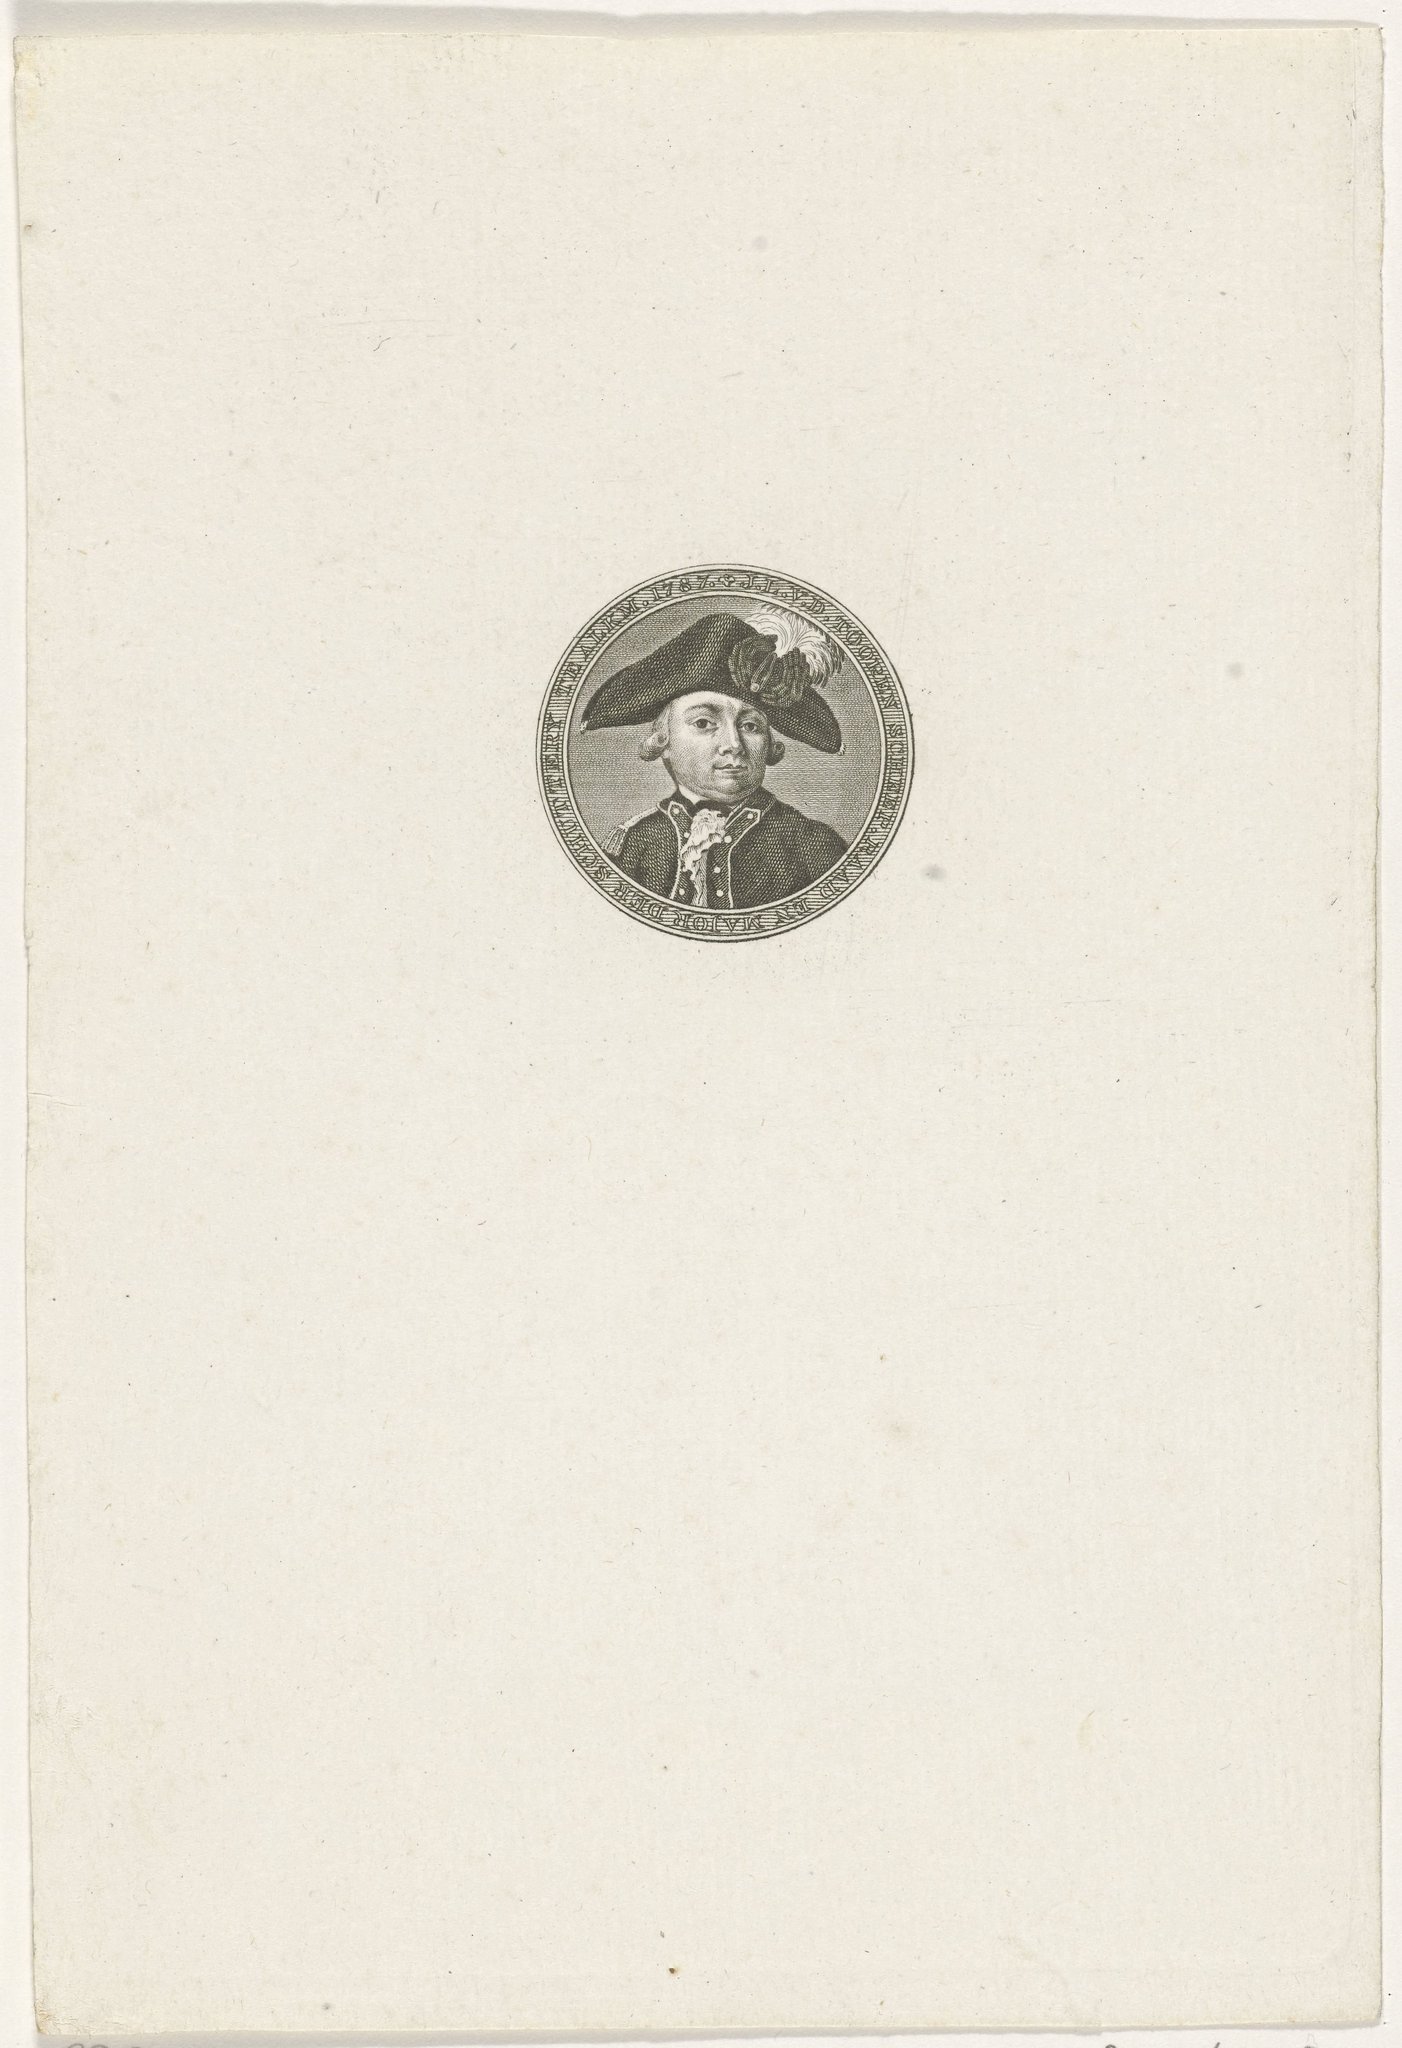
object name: print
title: Portret van Jan Lucas van der Tooren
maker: abraham jacobsz. hulk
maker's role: print maker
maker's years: 1751-1817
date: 1787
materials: paper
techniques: engraving, etching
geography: paris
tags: jan lucas van der tooren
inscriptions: collector's mark: Lugt 2228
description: Buste van Jan Lucas van der Tooren in een medaillon met randschrift in het Nederlands.